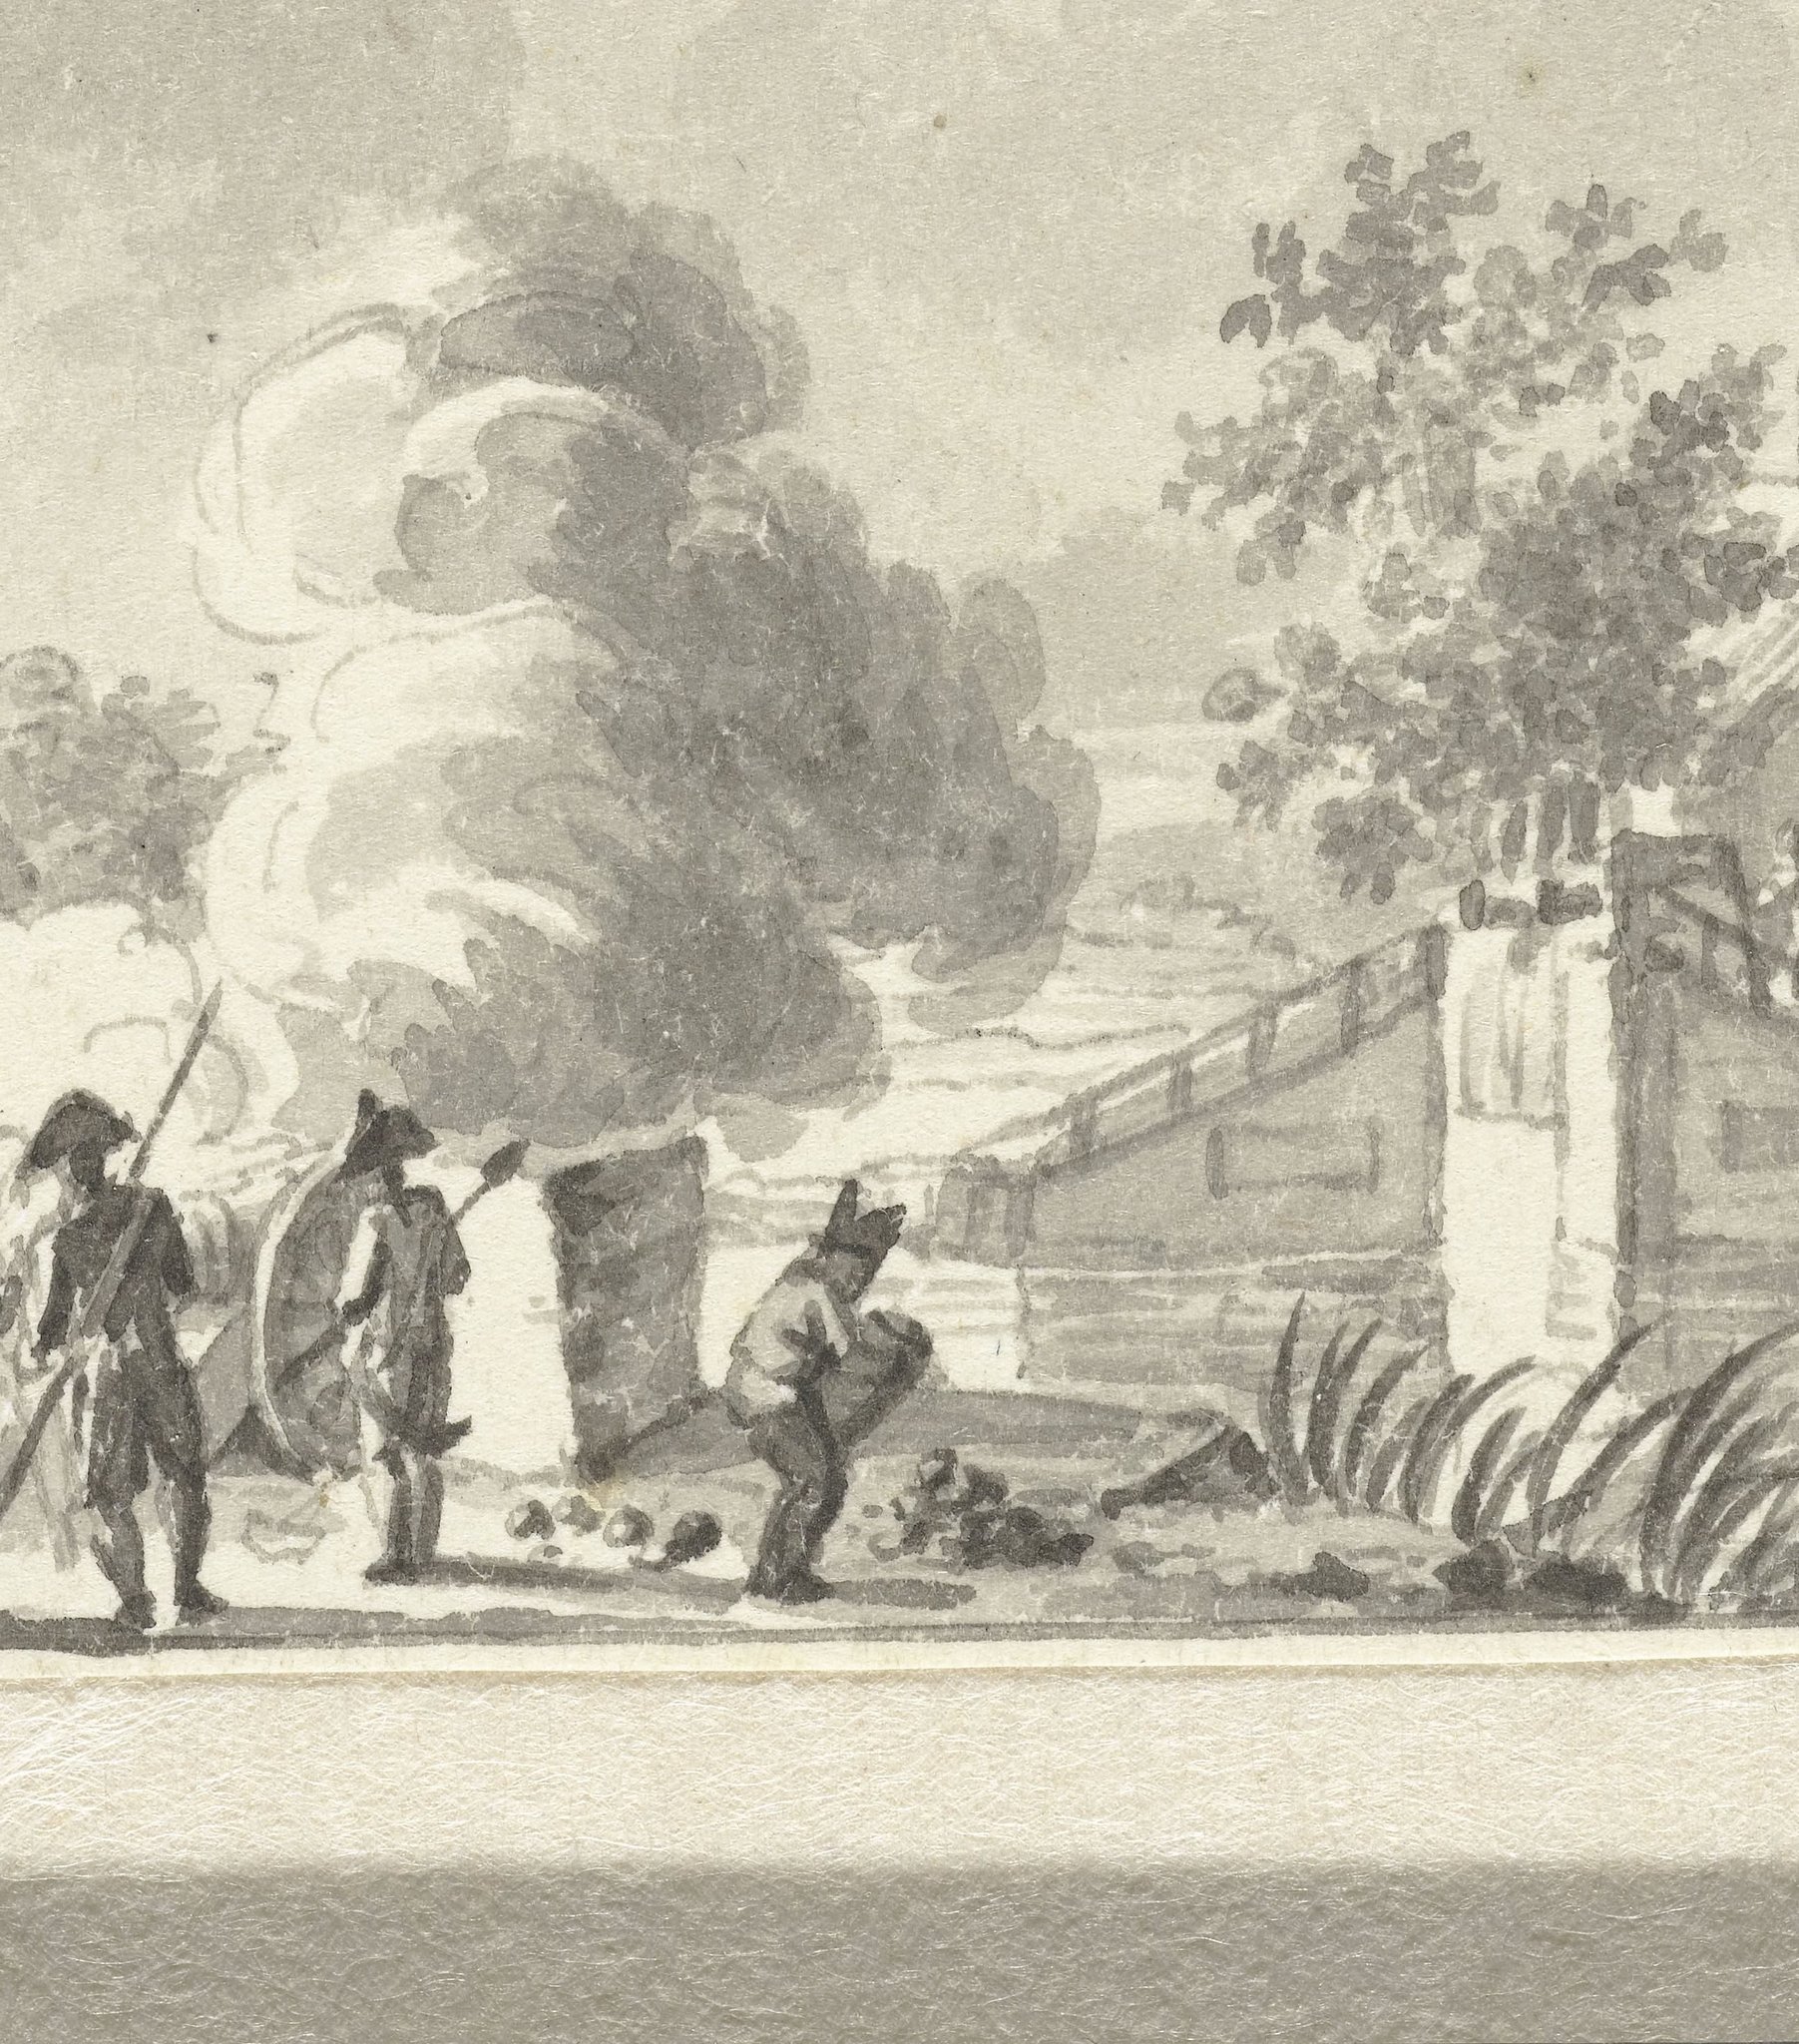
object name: design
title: In 't Jaar 1787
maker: Anonymous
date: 1789-1810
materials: ink, paper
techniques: brush, pen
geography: netherlands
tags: battle (+ land forces)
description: Gevechten bij een brug, waarschijnlijk de aanval door de Pruisische troepen bij Ouderkerk aan de Amstel op de afgebroken brug, 1 oktober 1787.